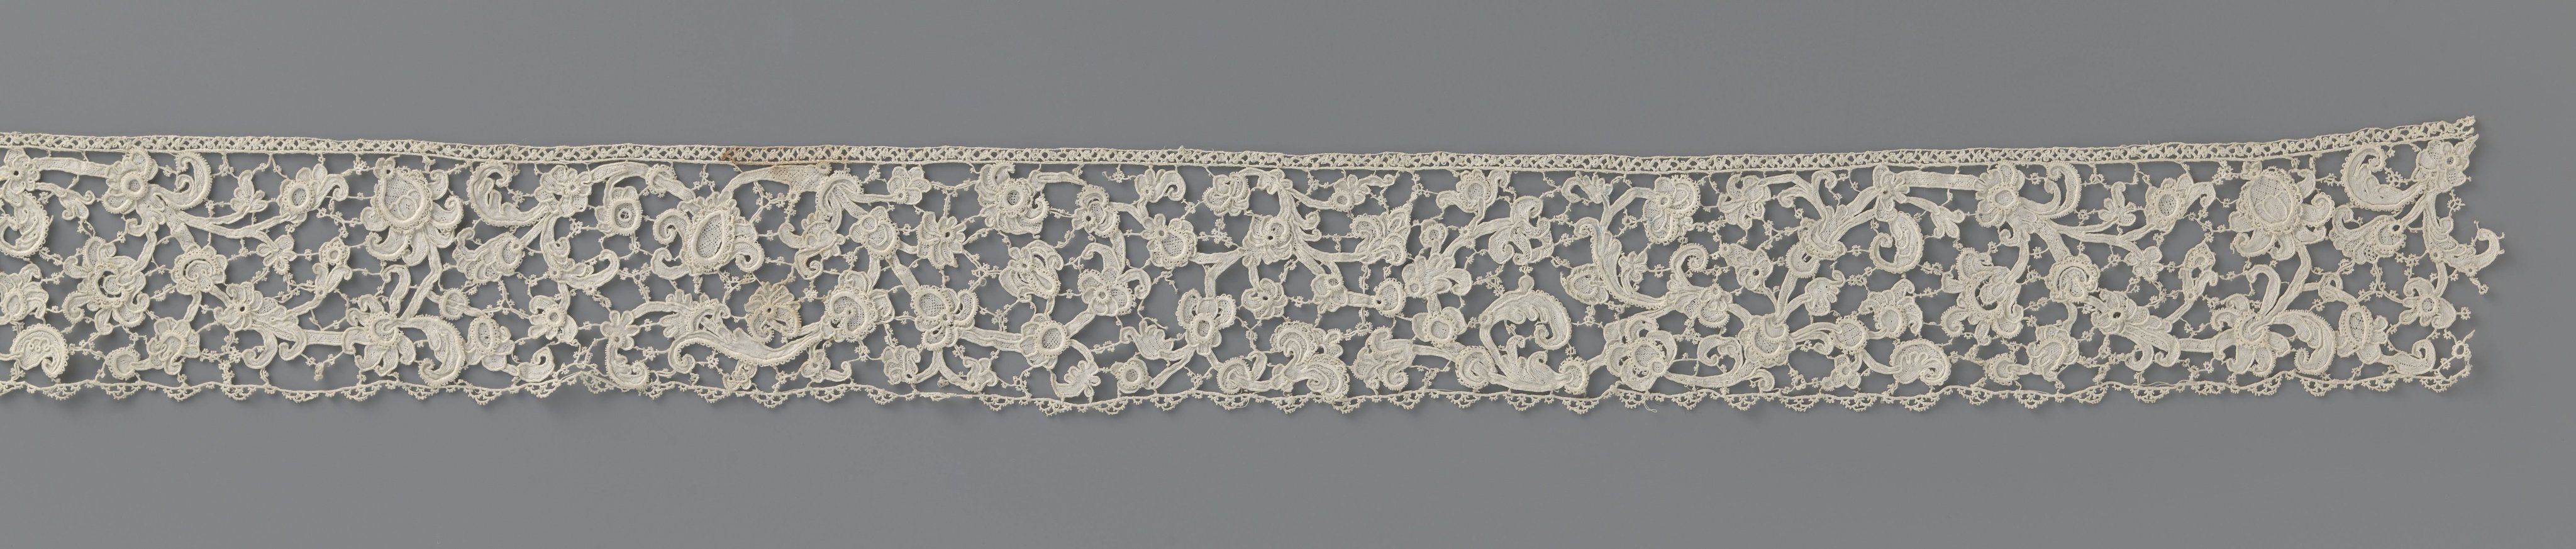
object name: strip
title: Strook naaldkant met druppelvormige bloem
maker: Anonymous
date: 1685-1699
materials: linen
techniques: rose point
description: Strook naturelkleurig naaldkant, Venetiaanse rozenkant. Patroon met veelsoortige bloemen en acanthusbladeren aan ranken, in een repetitief motief. Eén van de grotere bloemen is druppelvormig en heeft aan weerszijden bladvoluten. Onregelmatige open spijlengrond met picots. De bovenzijde is afgezet met een rand kloskant. De onderzijde is afgewerkt met een rechte picotrand met boogjes.